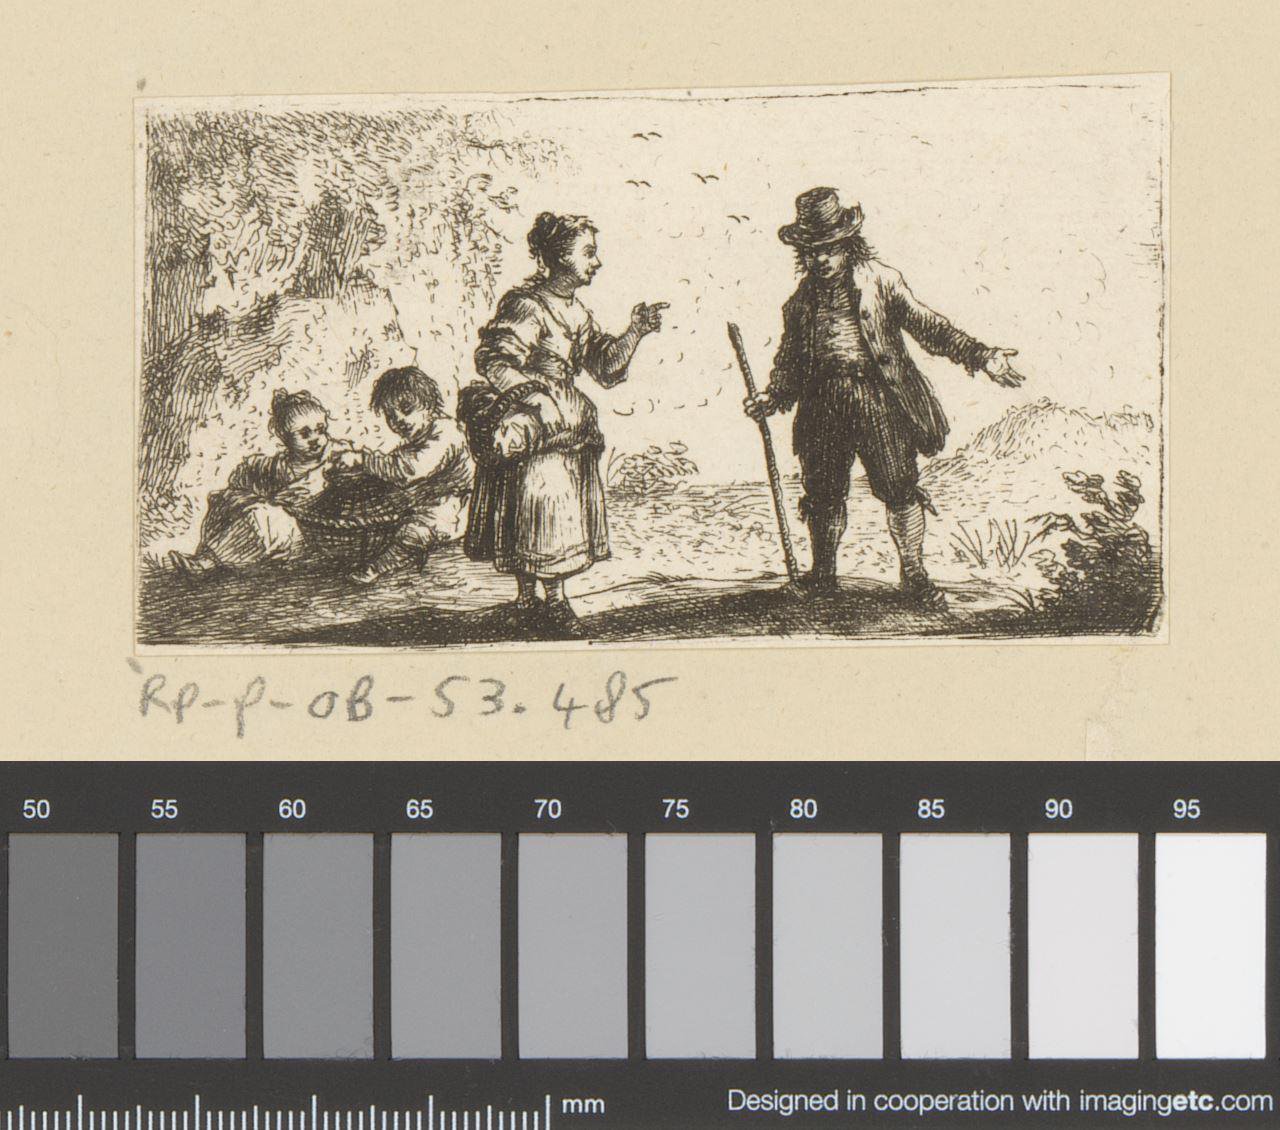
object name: print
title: Man pratend met vrouw, twee kinderen zitten met een korf langs kant van de weg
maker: johann andreas benjamin nothnagel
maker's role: print maker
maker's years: 1729-1804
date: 1739-1804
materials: paper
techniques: etching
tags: 'en route', traveller under way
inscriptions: collector's mark: Lugt 240